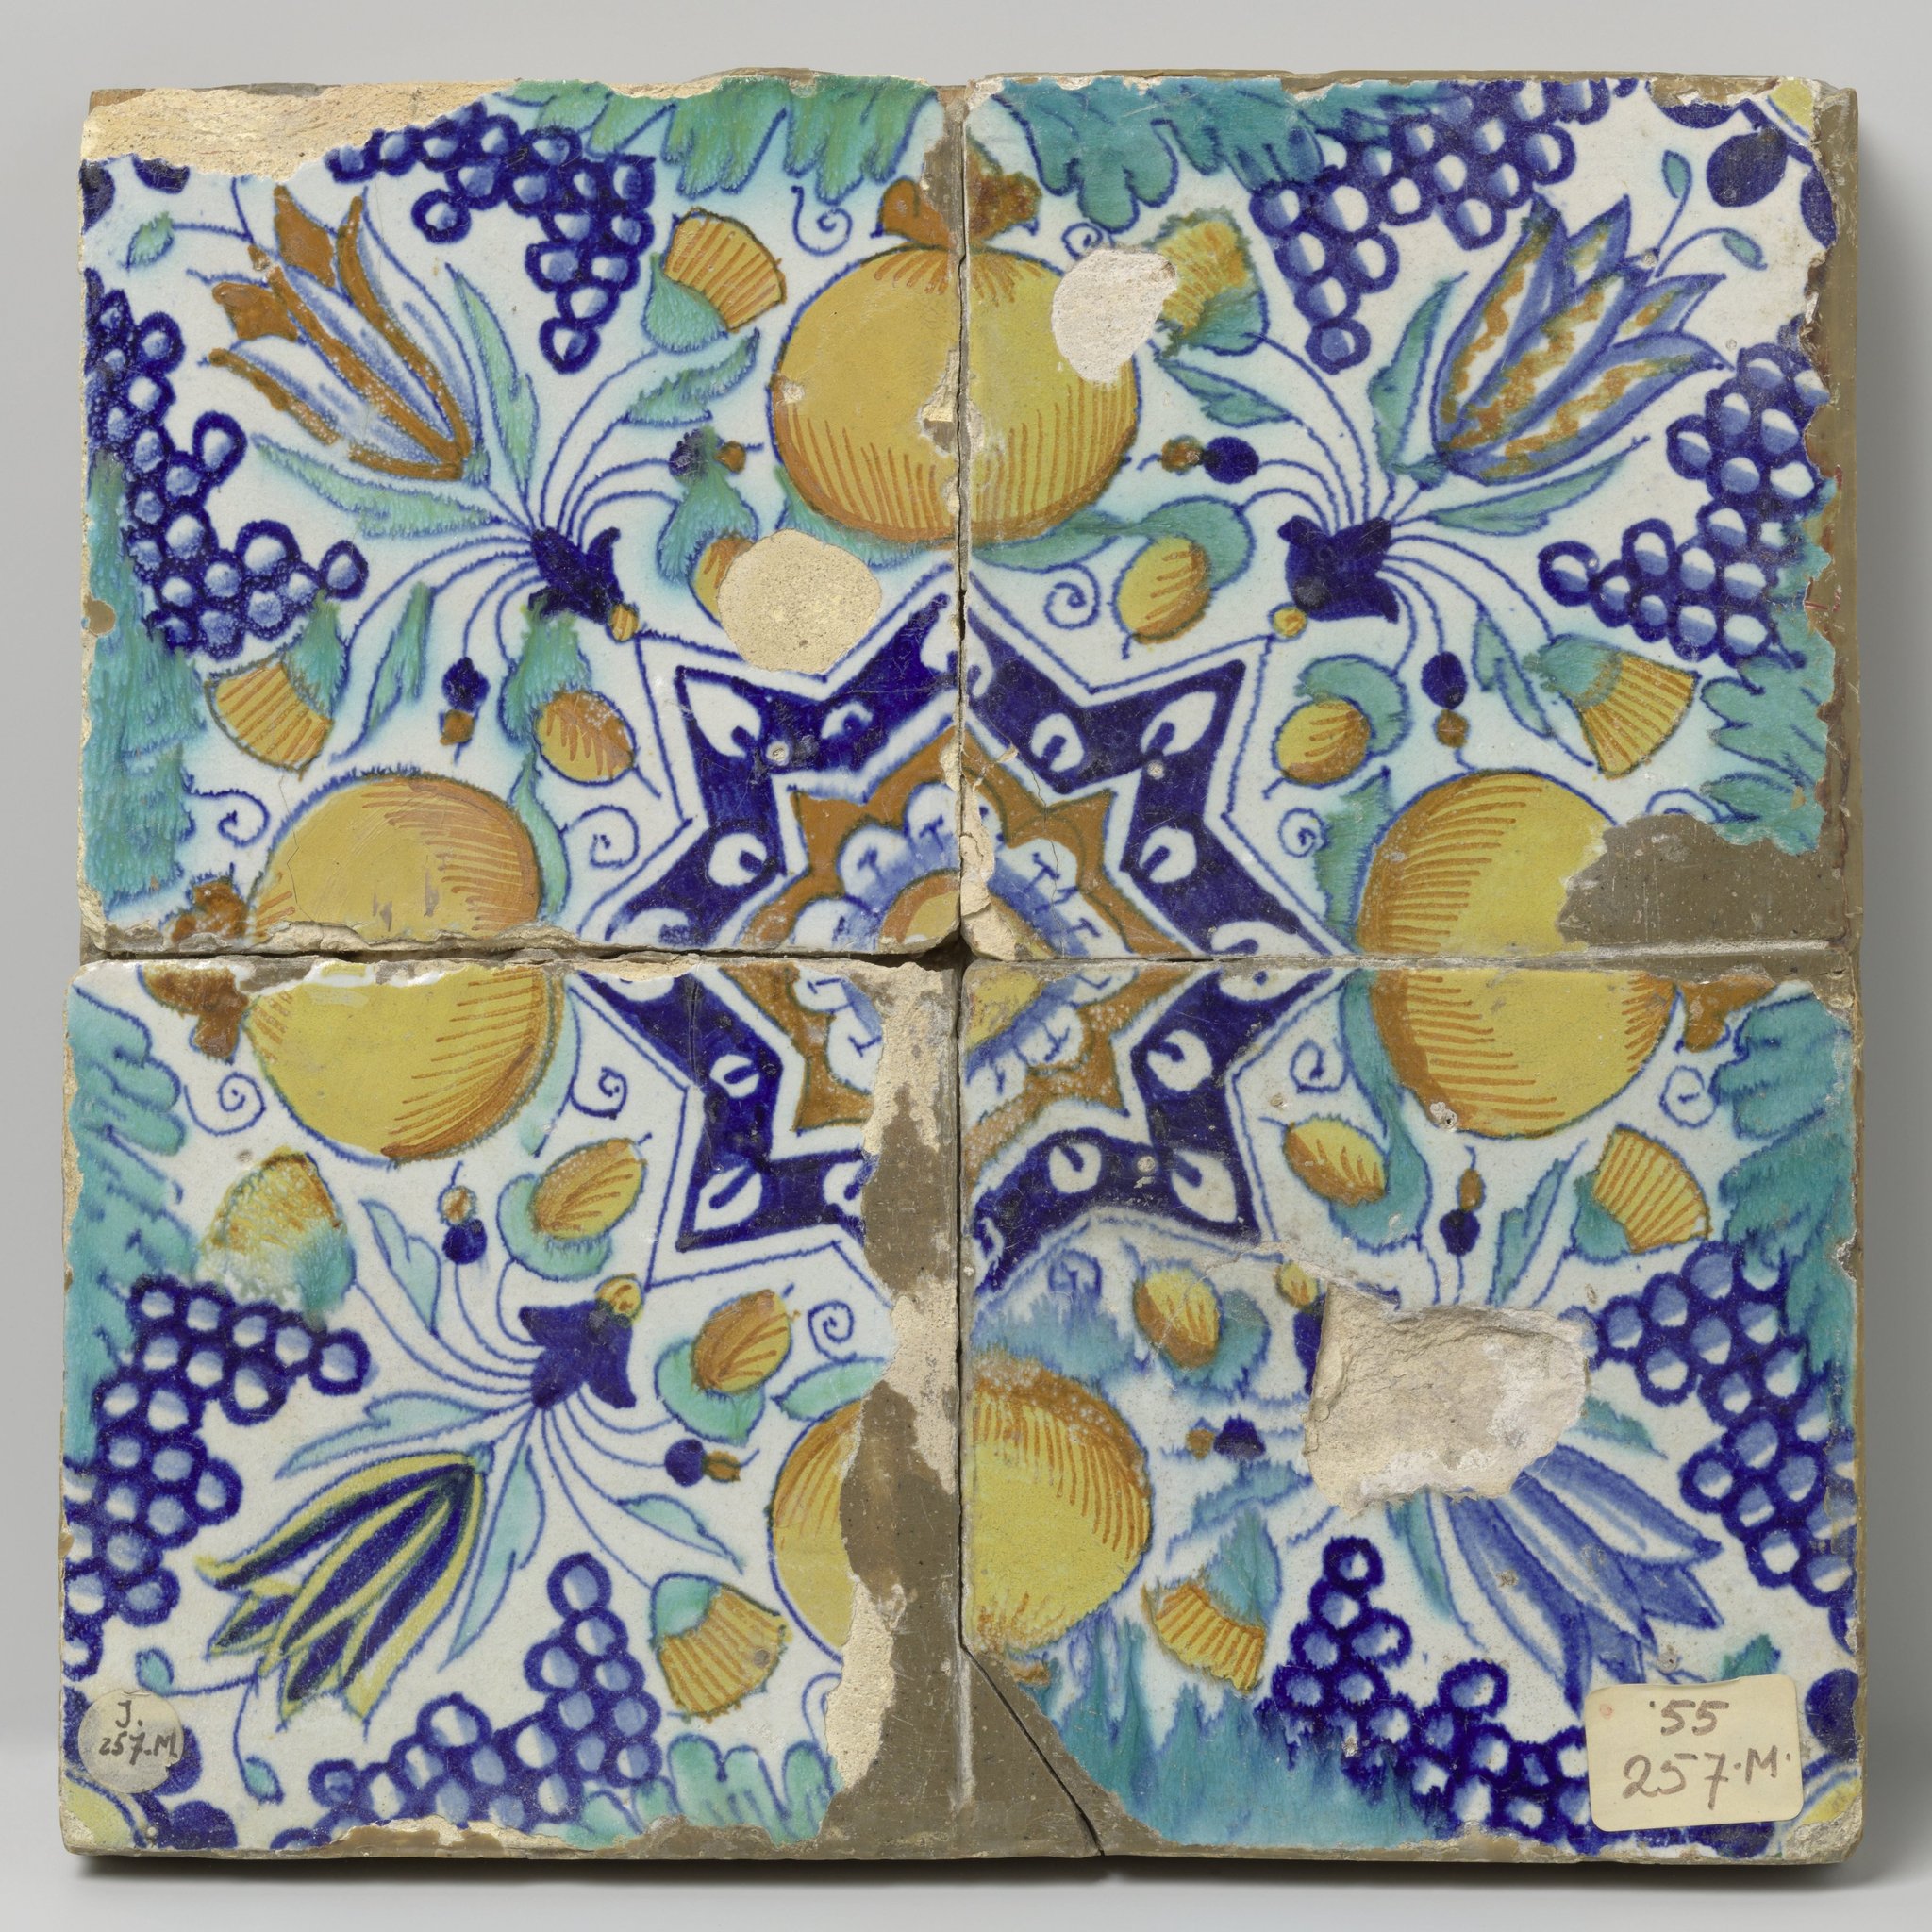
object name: tile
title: Veld van vier tegels met patroon van druiventrossen, sterren, tulpen en granaatappels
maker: Anonymous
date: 1600-1625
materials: earthenware, glaze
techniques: maiolica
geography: netherlands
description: Veld van vier tegels (2 x 2) met een veelkleurig (blauw, groen, geel, oranje en paars) patroon gevormd door vier tegels met granaatappels, druiventrossen en tulpen rond een ster.